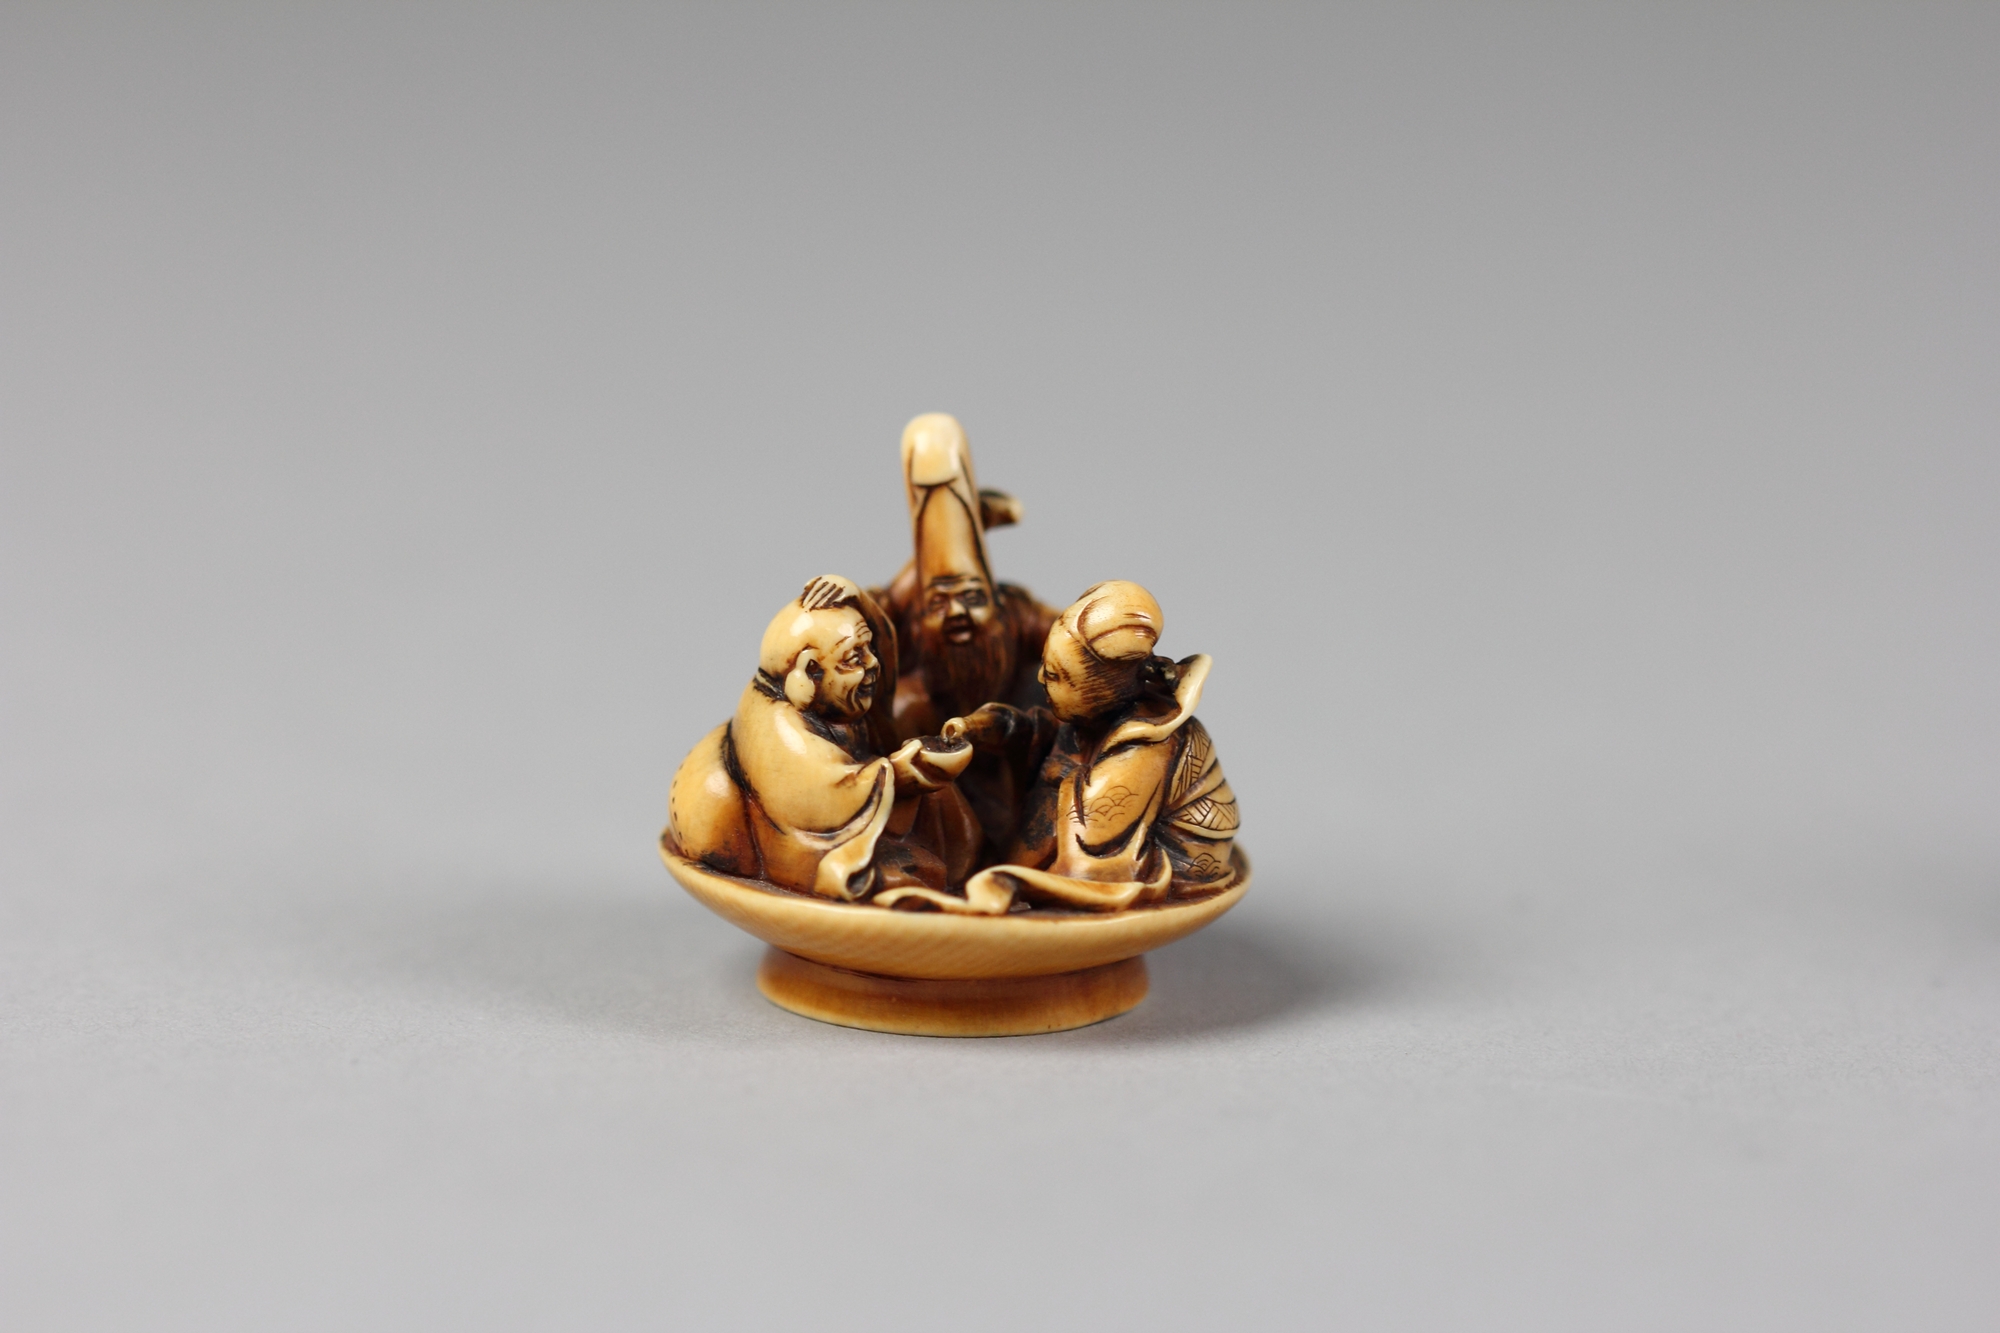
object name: netsuke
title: Netsuke of Fukurokujin, Hotei and Benten in Sake Dish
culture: japanese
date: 1834-1866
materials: ivory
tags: men